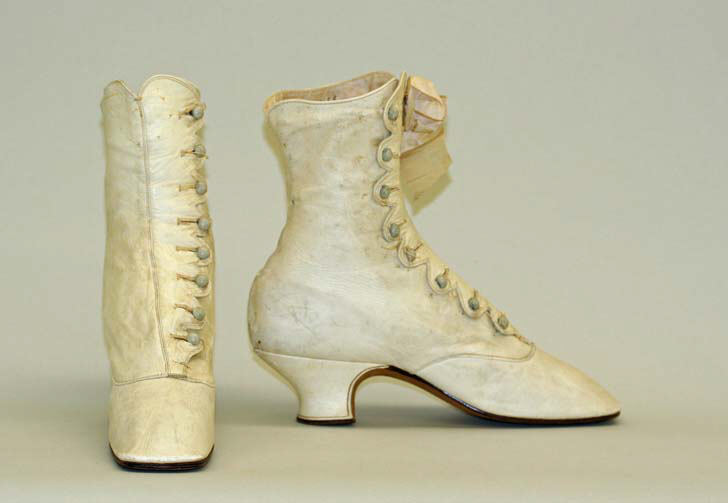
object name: wedding shoe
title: Wedding shoes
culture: american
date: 1872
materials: leather